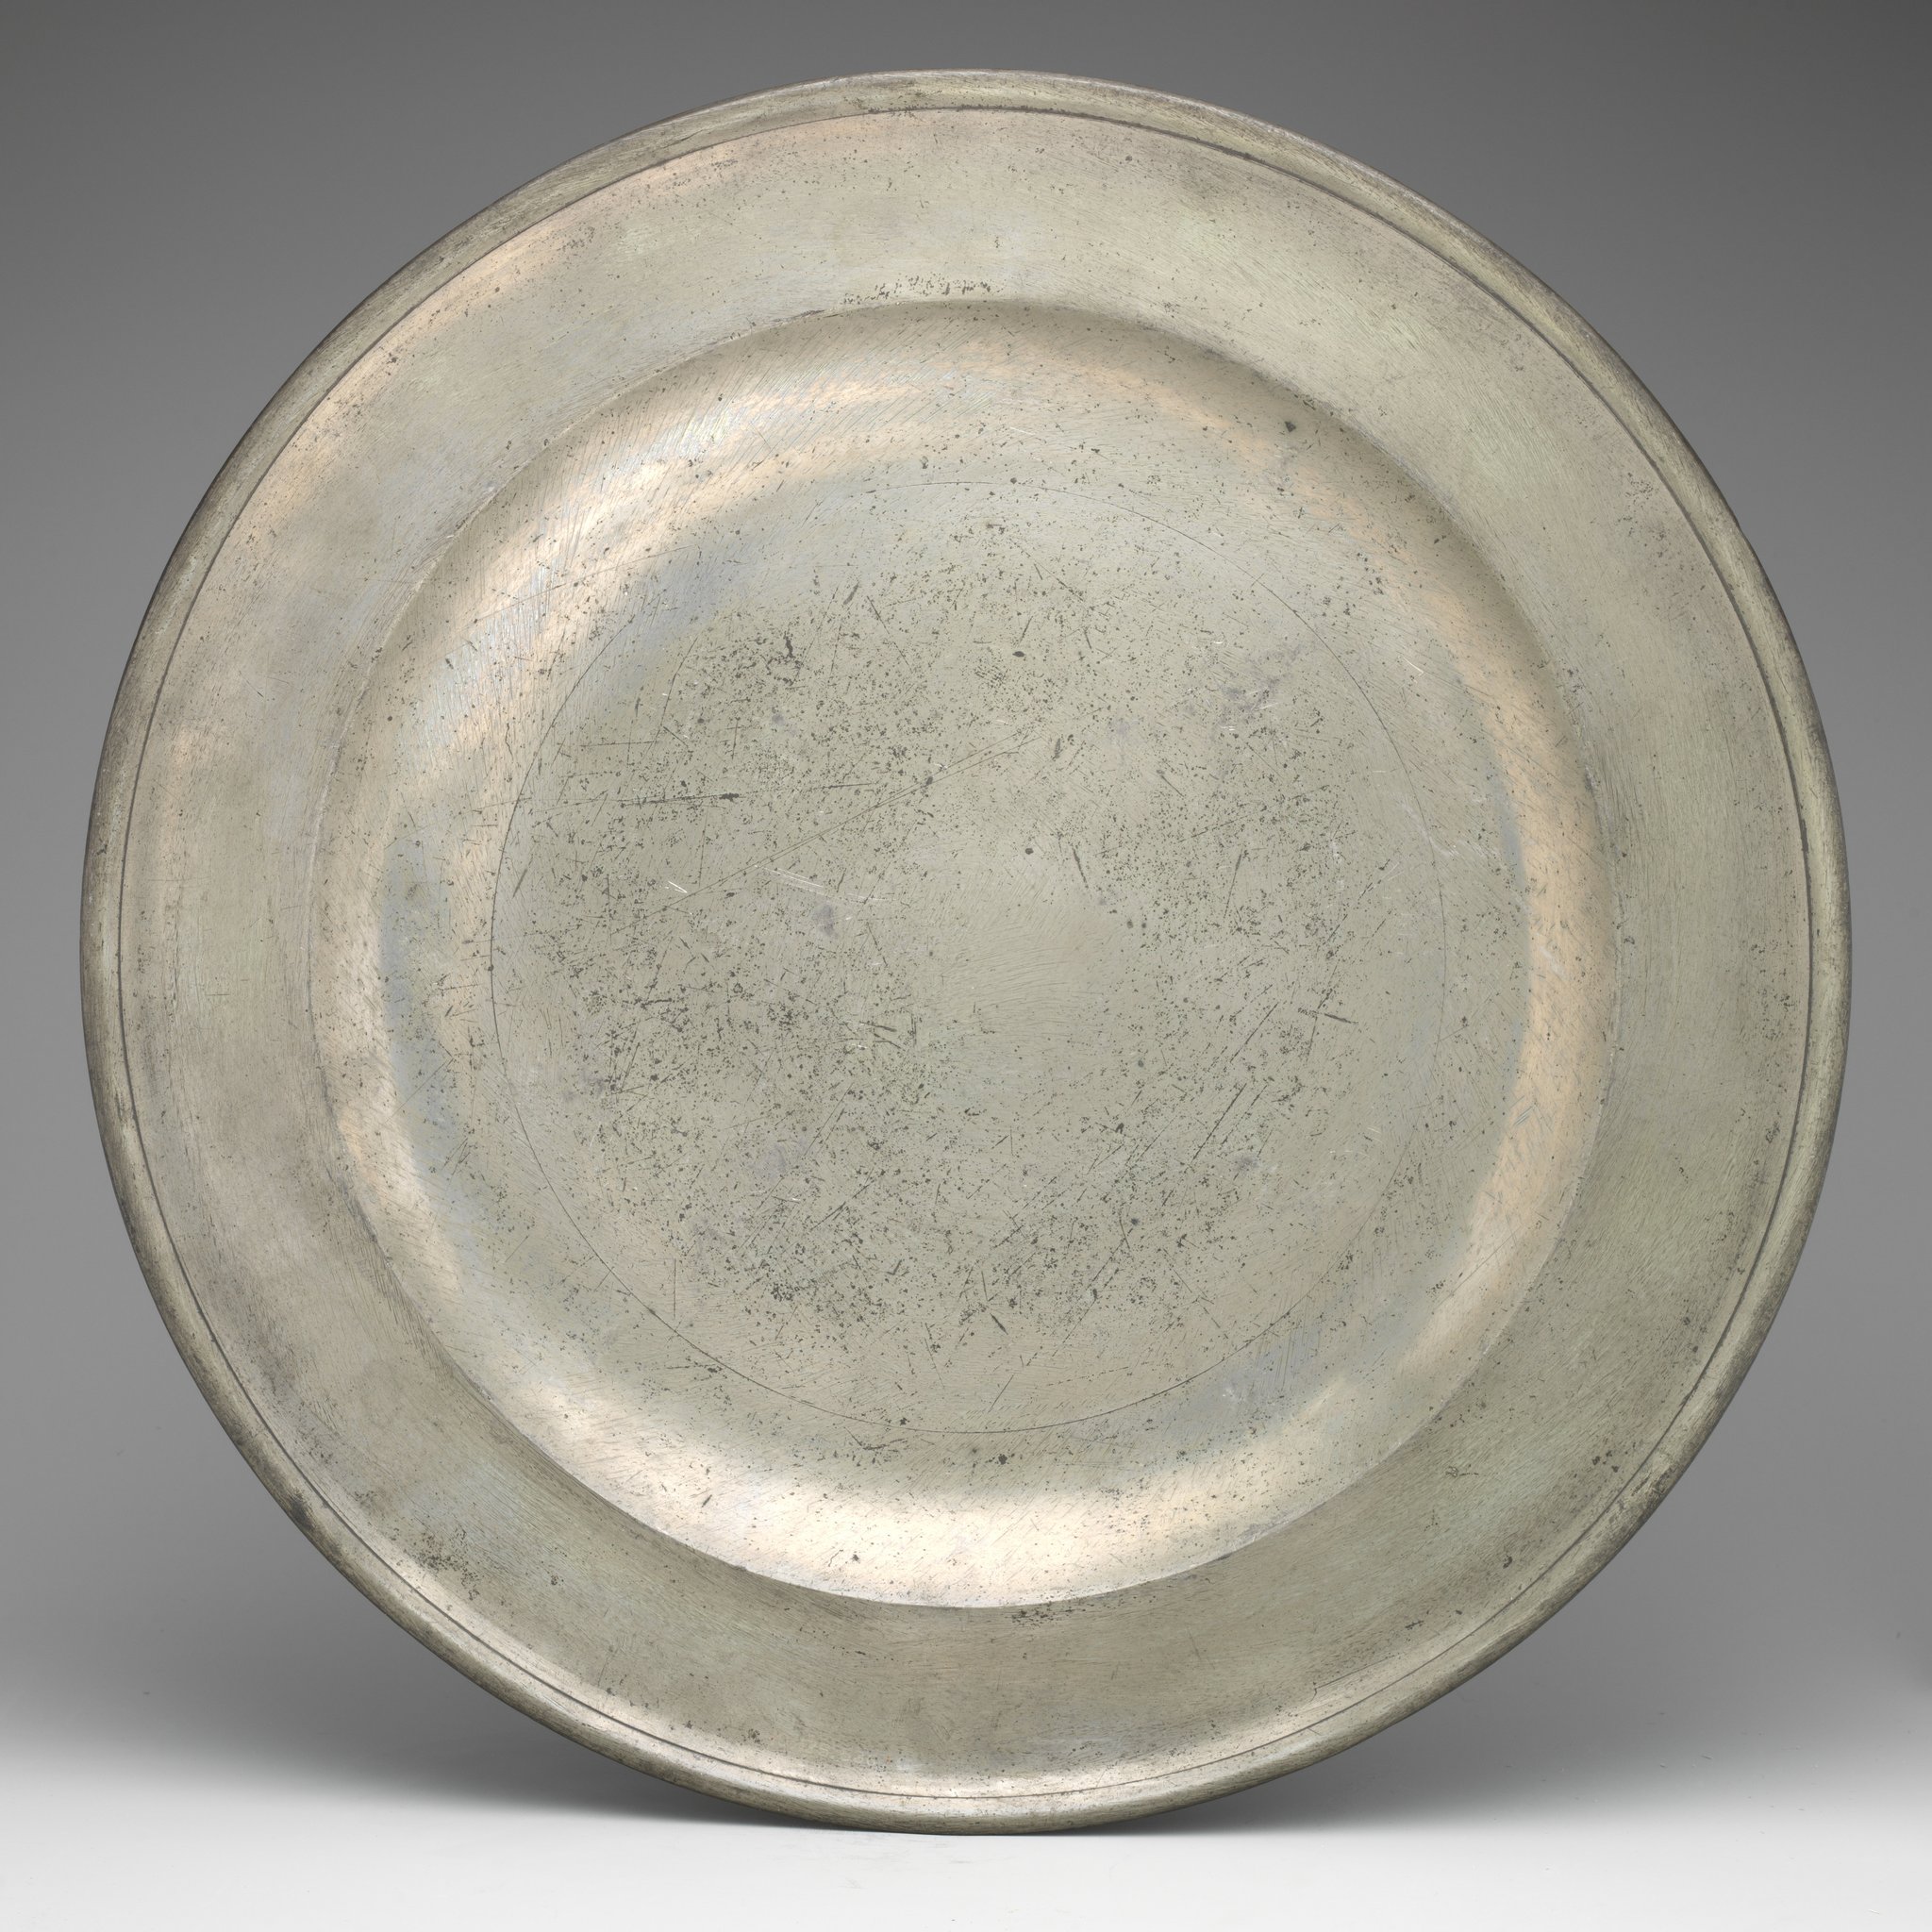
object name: platter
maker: thomas fasson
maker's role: maker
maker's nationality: british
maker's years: 1744-1844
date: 1701-1800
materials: pewter